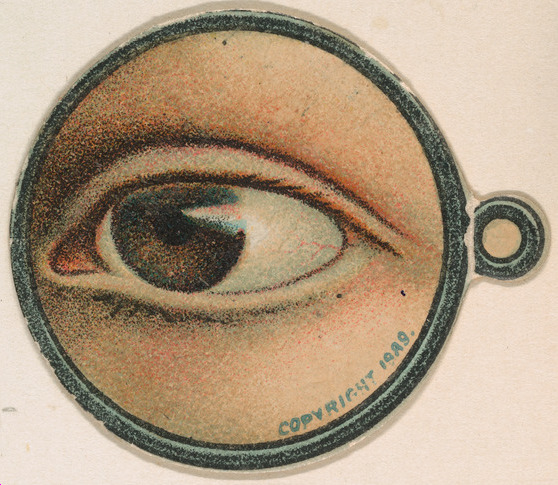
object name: print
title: Monocle and Eye (brown), from Jocular Ocular series (N221) issued by Kinney Bros.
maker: kinney brothers tobacco company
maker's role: publisher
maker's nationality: american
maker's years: 1869-2011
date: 1889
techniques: color lithograph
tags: eyes